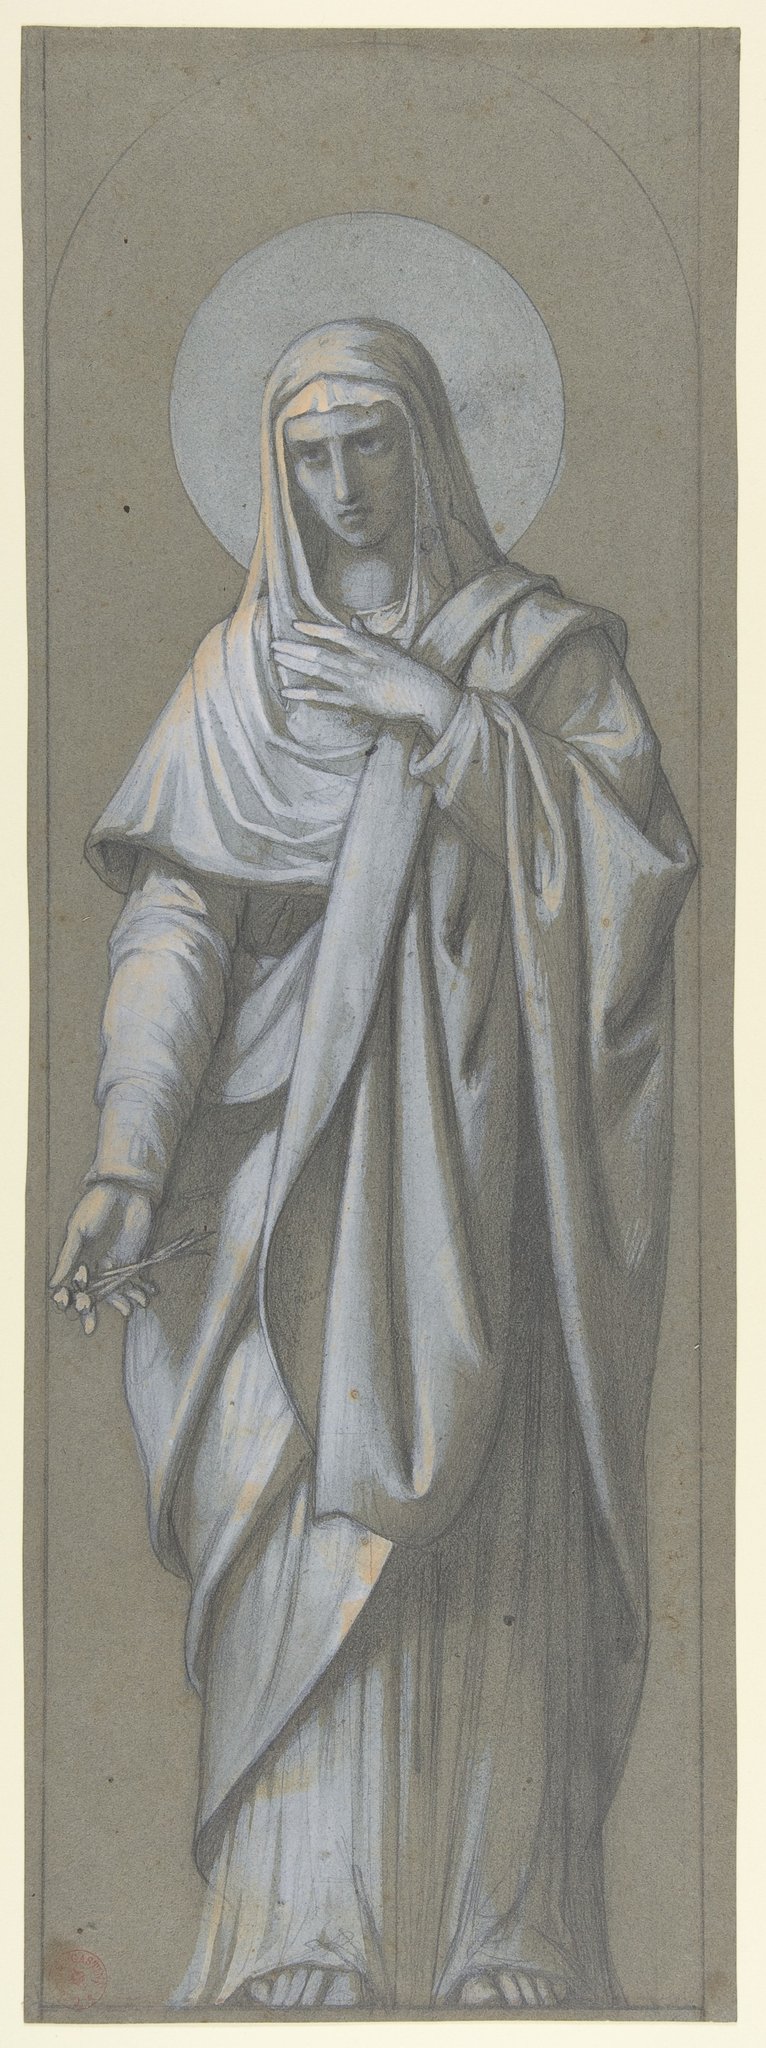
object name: drawing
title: Mater Dolorosa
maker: camille-auguste gastine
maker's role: artist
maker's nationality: french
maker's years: 1819-1867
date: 1835-1867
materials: gouache, graphite, paper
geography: france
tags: virgin mary